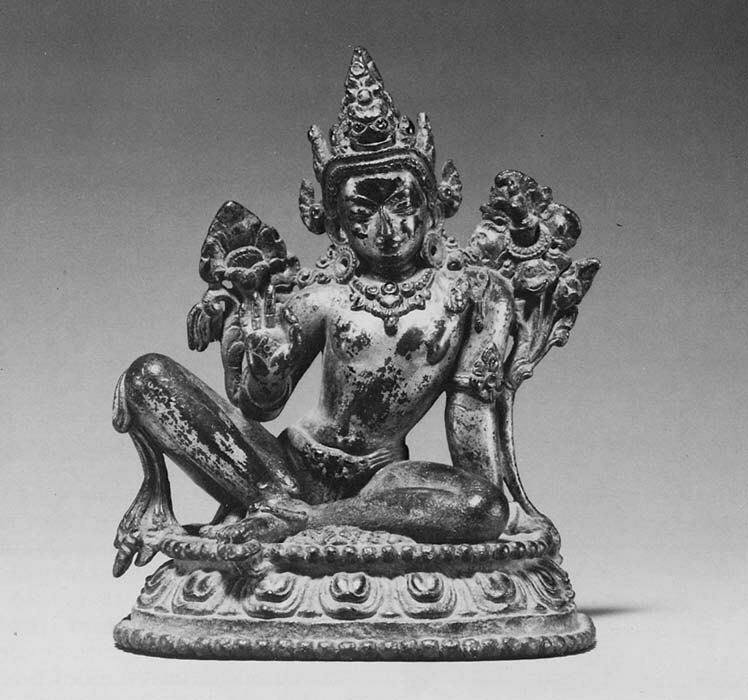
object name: figurine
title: Seated Bodhisattva Maitreya (The Buddha of the Future)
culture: nepali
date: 1250-1350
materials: copper alloy, gilt, stone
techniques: inlay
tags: buddhism,bodhisattvas,maitreya